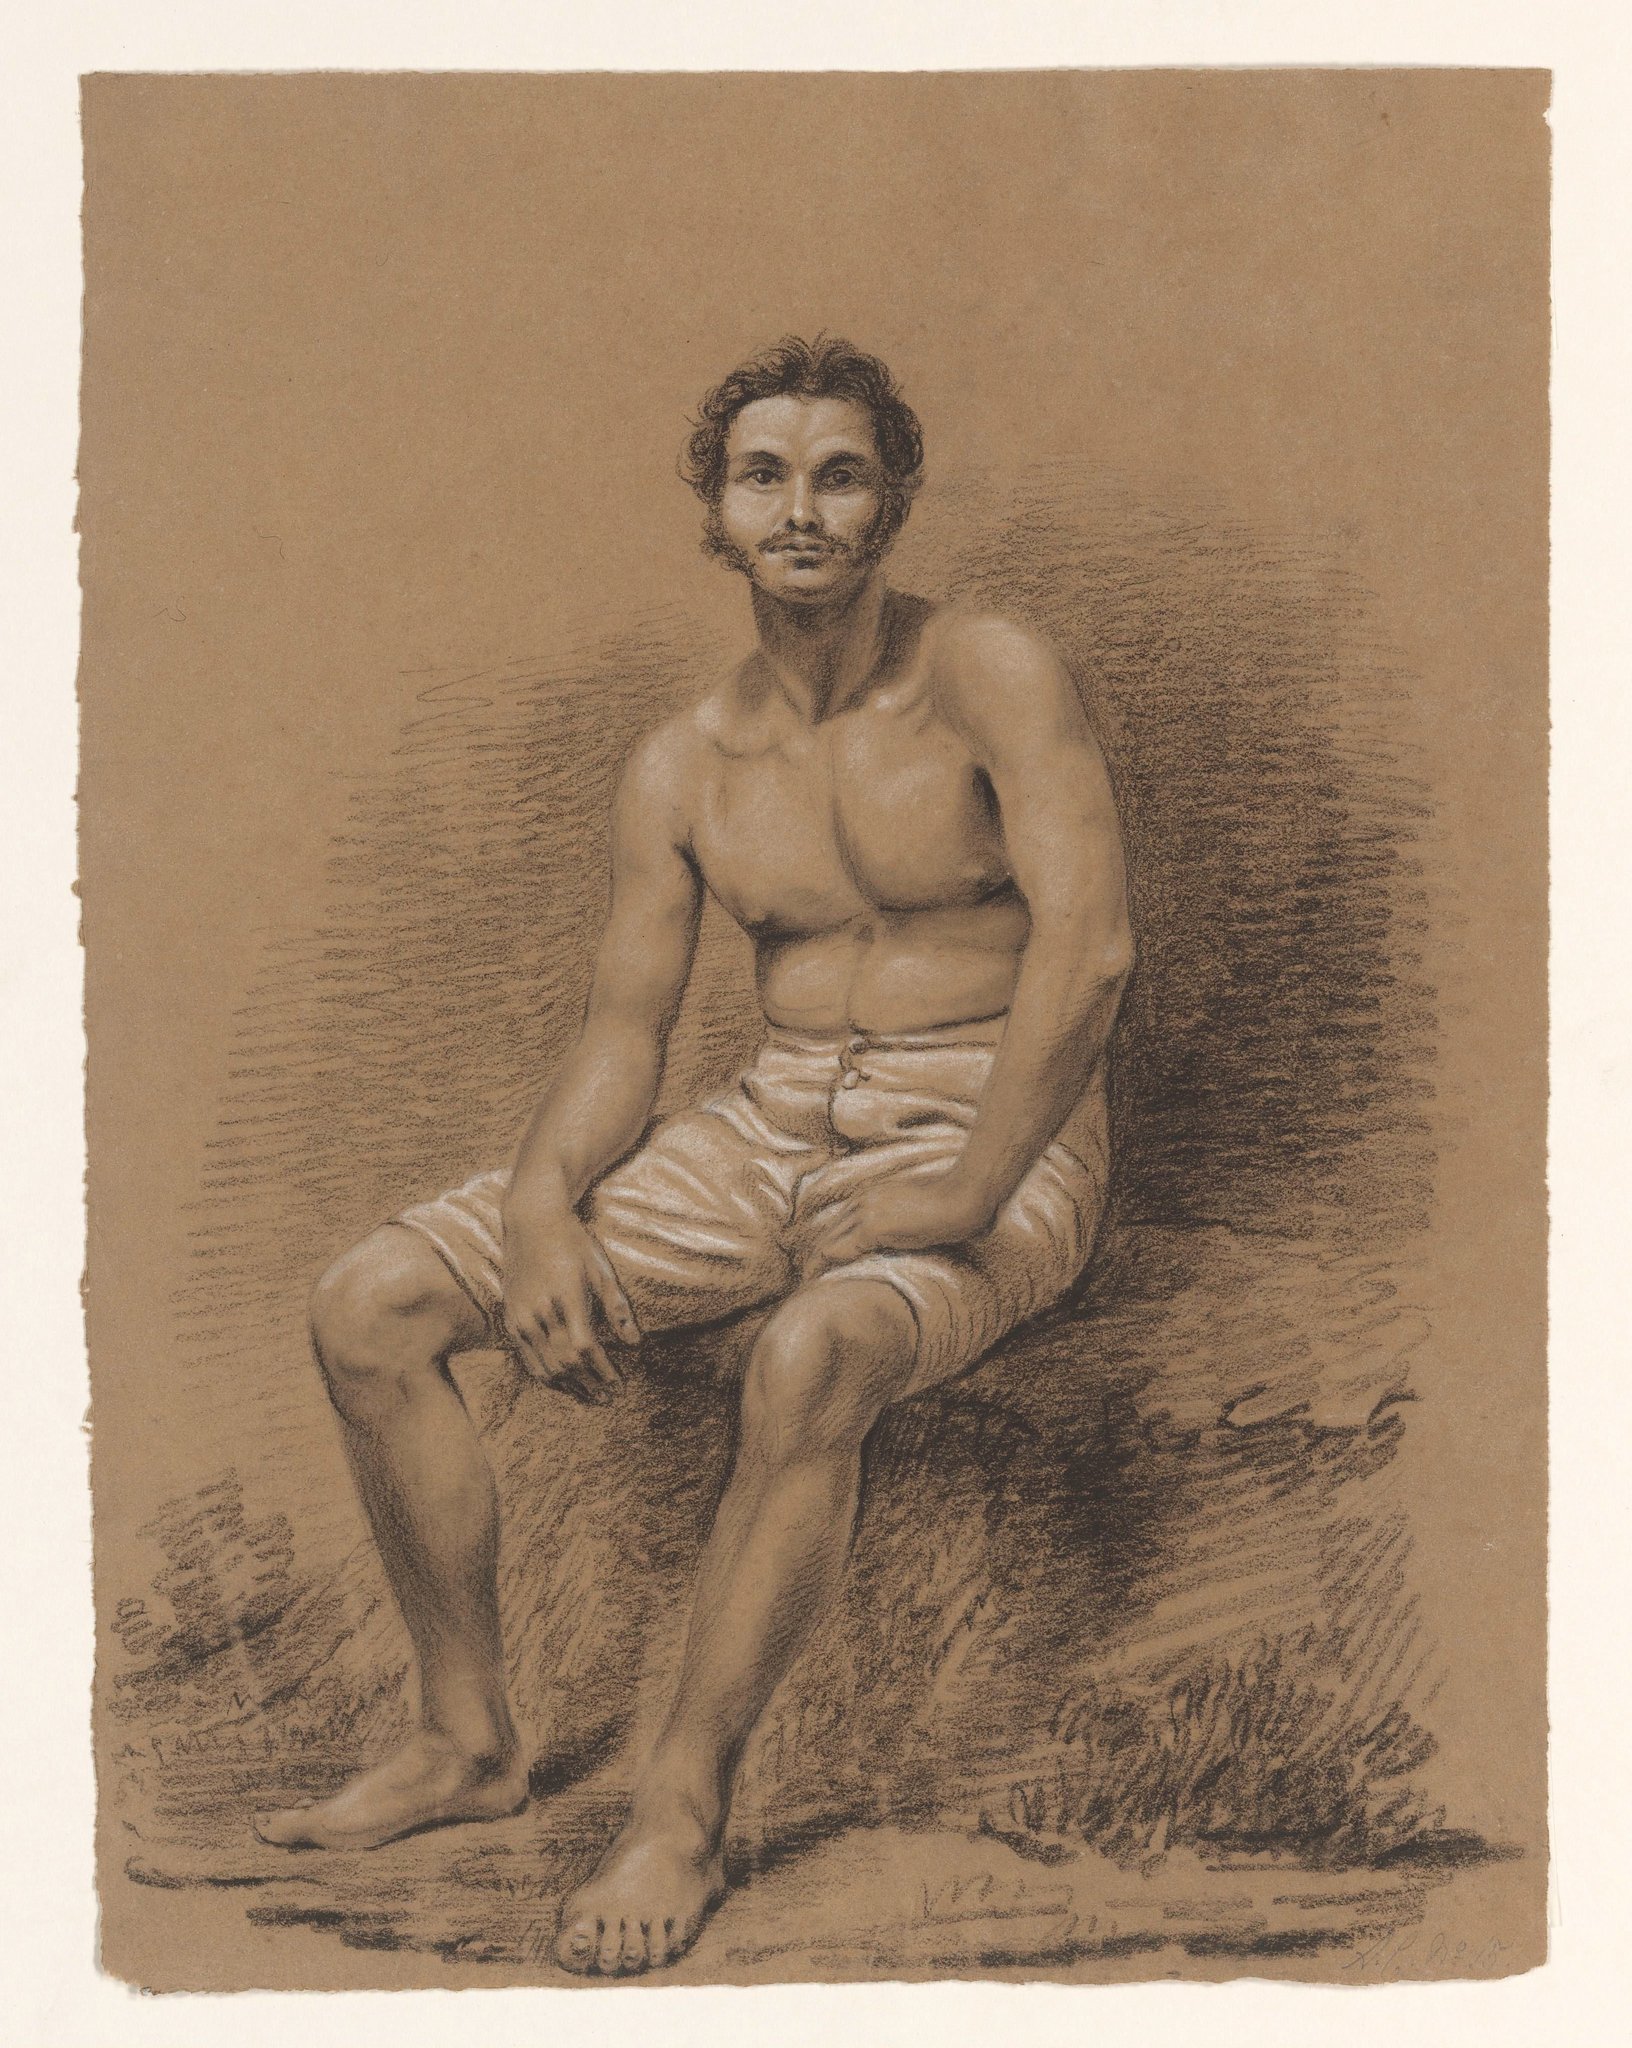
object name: drawing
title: Kopstudie van een man, driekwart naar rechts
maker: alexander cranendoncq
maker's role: draughtsman, print maker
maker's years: 1799-1869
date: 1809-1869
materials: chalk, paper